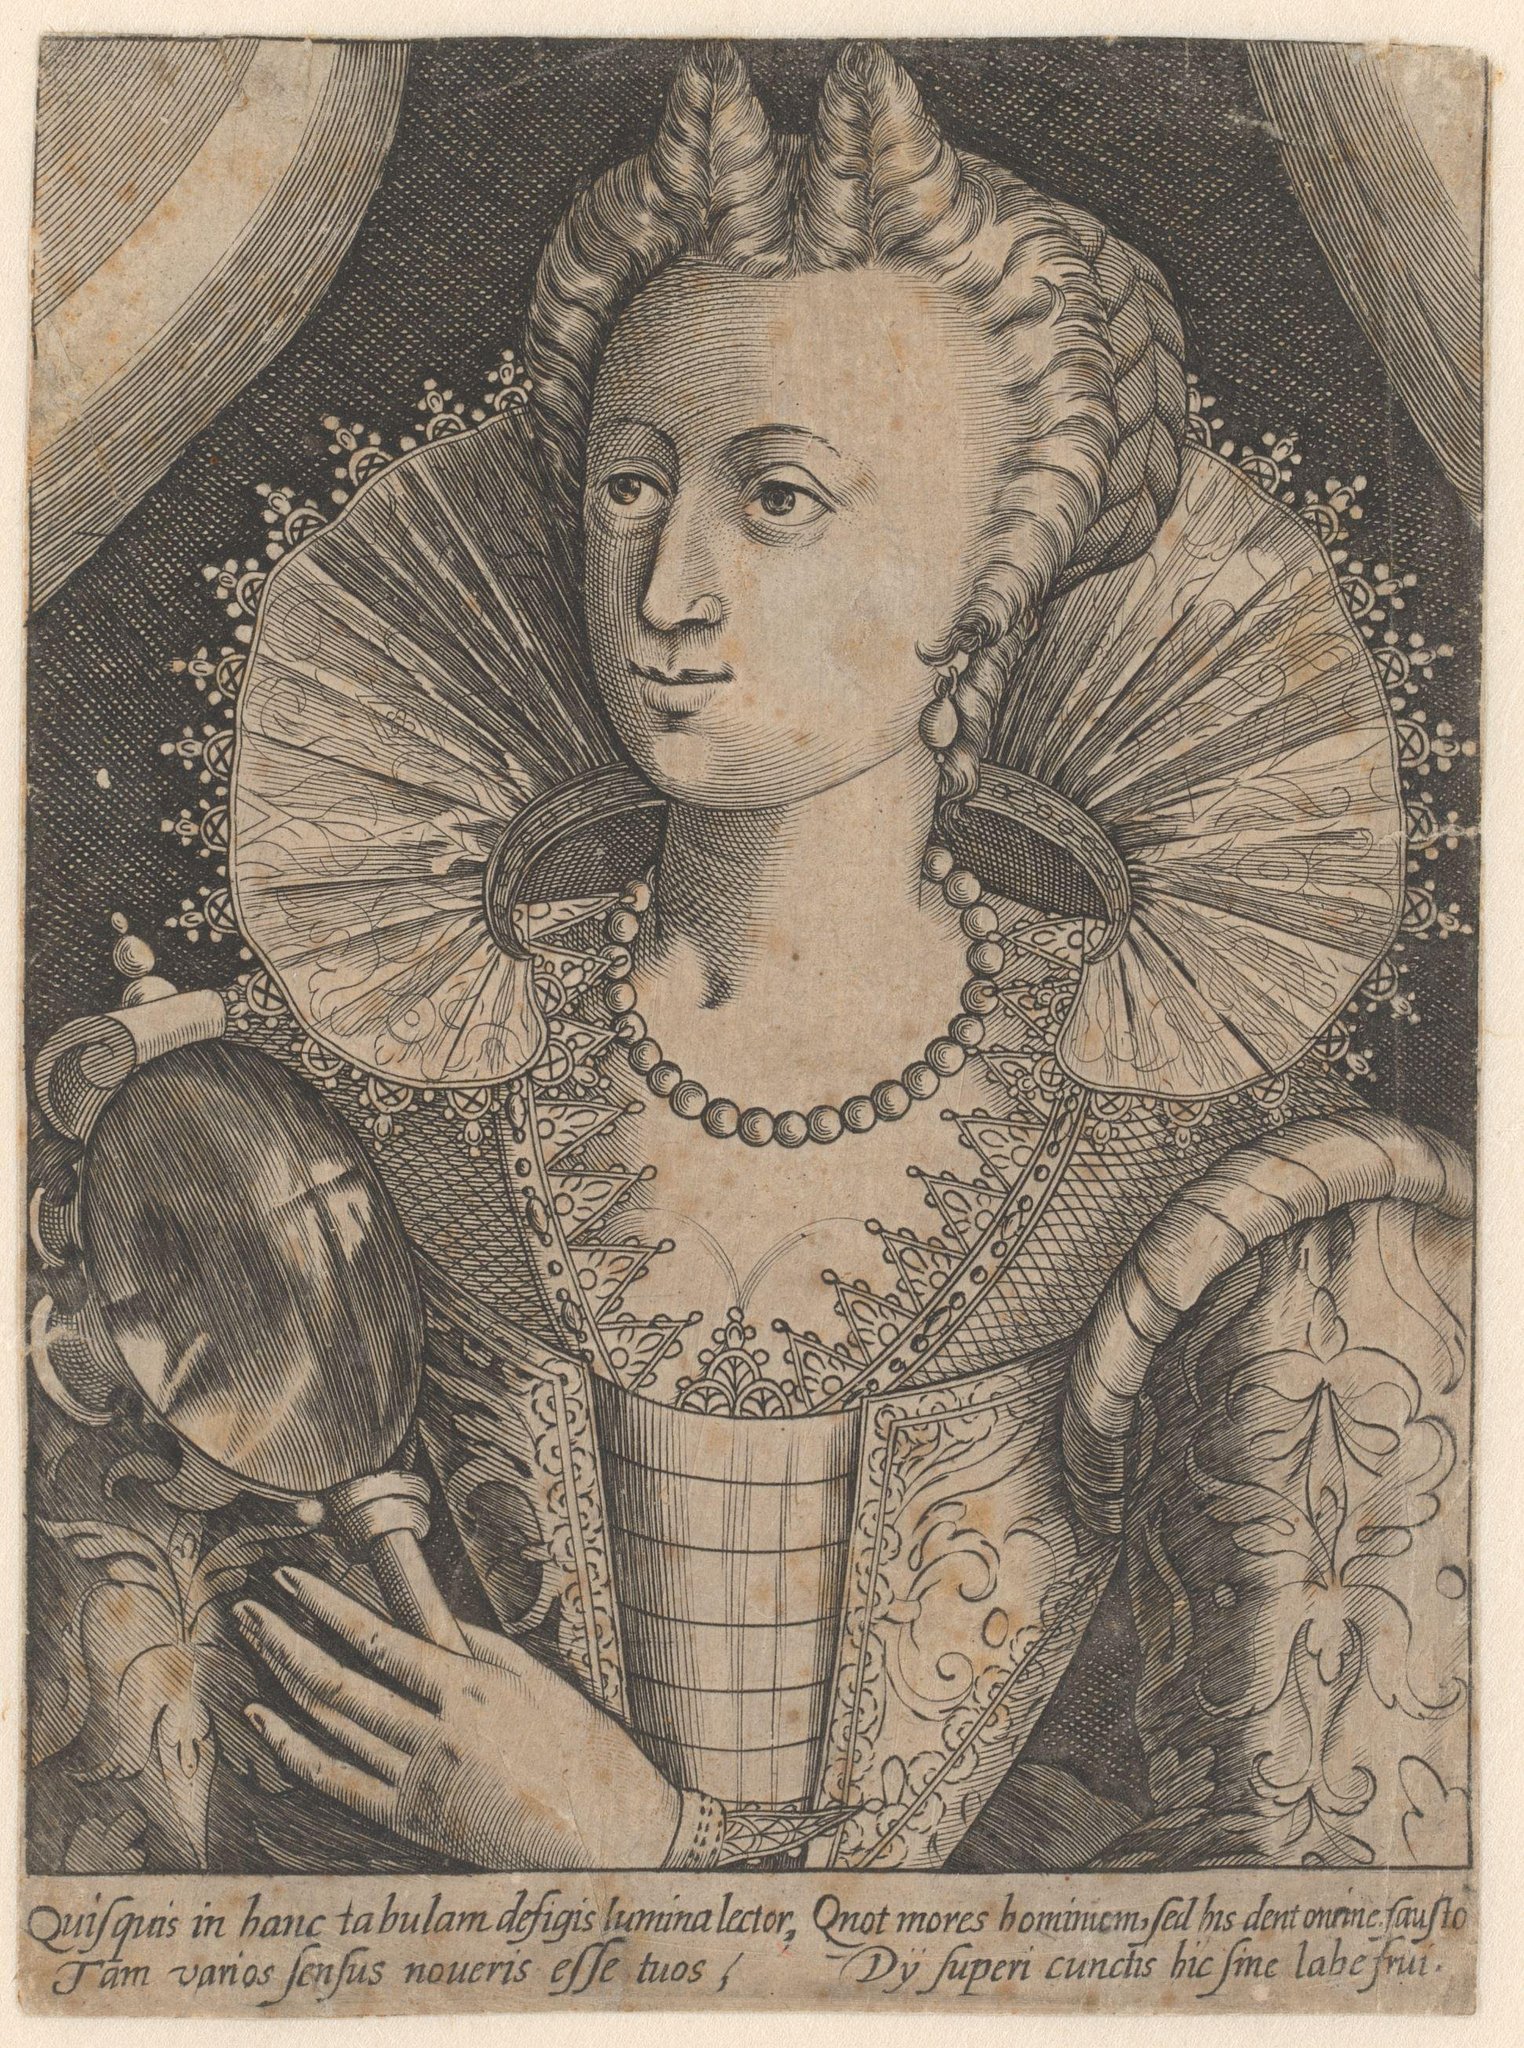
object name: print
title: Zintuig Gezicht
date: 1590-1620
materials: paper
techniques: engraving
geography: low countries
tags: looking in the mirror; (possibly: contemplation of own beauty - aa - (for) women), styles of hairdress - aa - ~ women, fashion, sight, looking (one of the five senses) - aa - female human figure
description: Zintuig Gezicht. Modieuze jonge vrouw met handspiegel en rijke kleding. Prent uit een serie met vijf zintuigen, waarin de vijf zintuigen zijn gepersonifieerd door vrouwen in modieuze kostuums en met kapsels uit verschillende landen en voorzien van attributen. Met onderschrift in het Latijn.